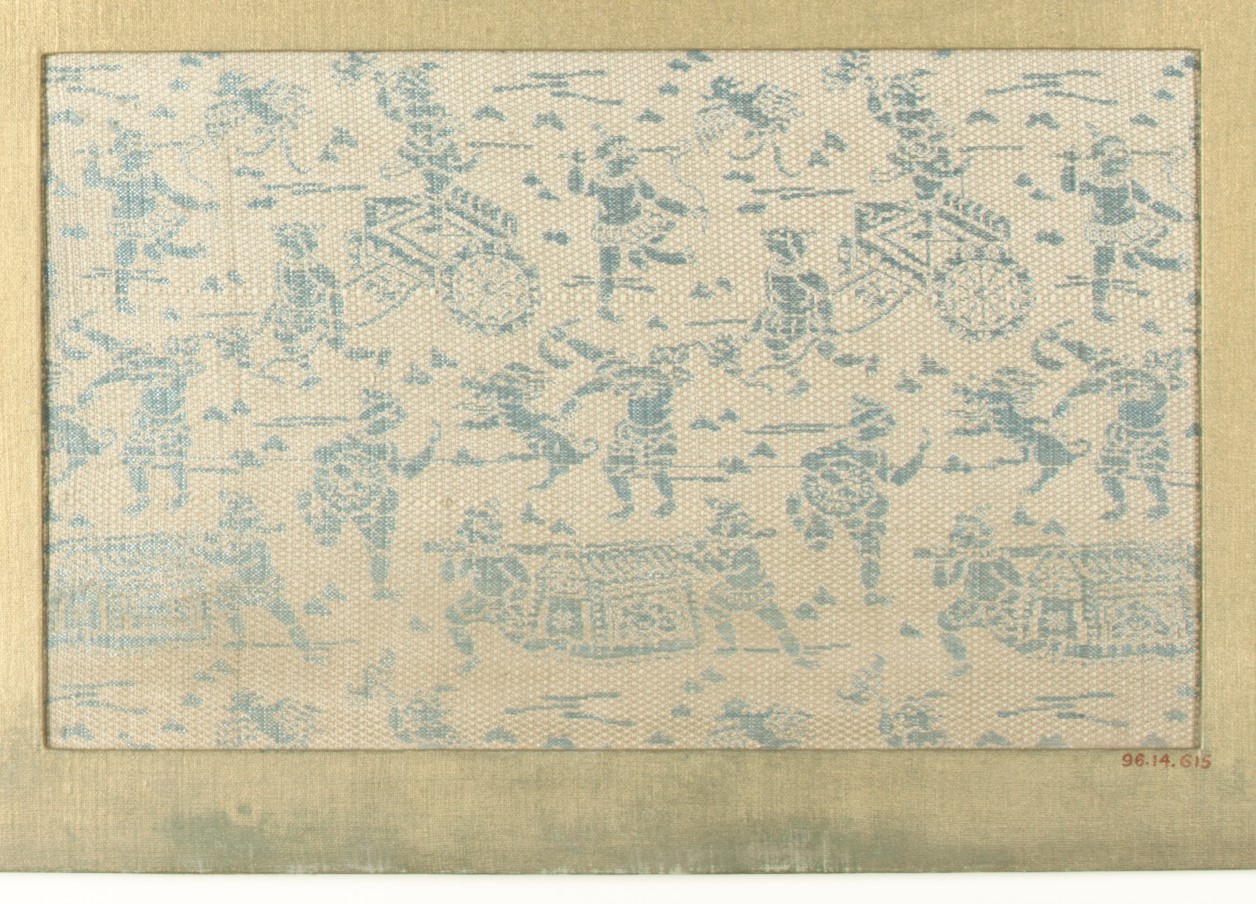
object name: piece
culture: japanese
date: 1701-1900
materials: silk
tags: human figures,carts